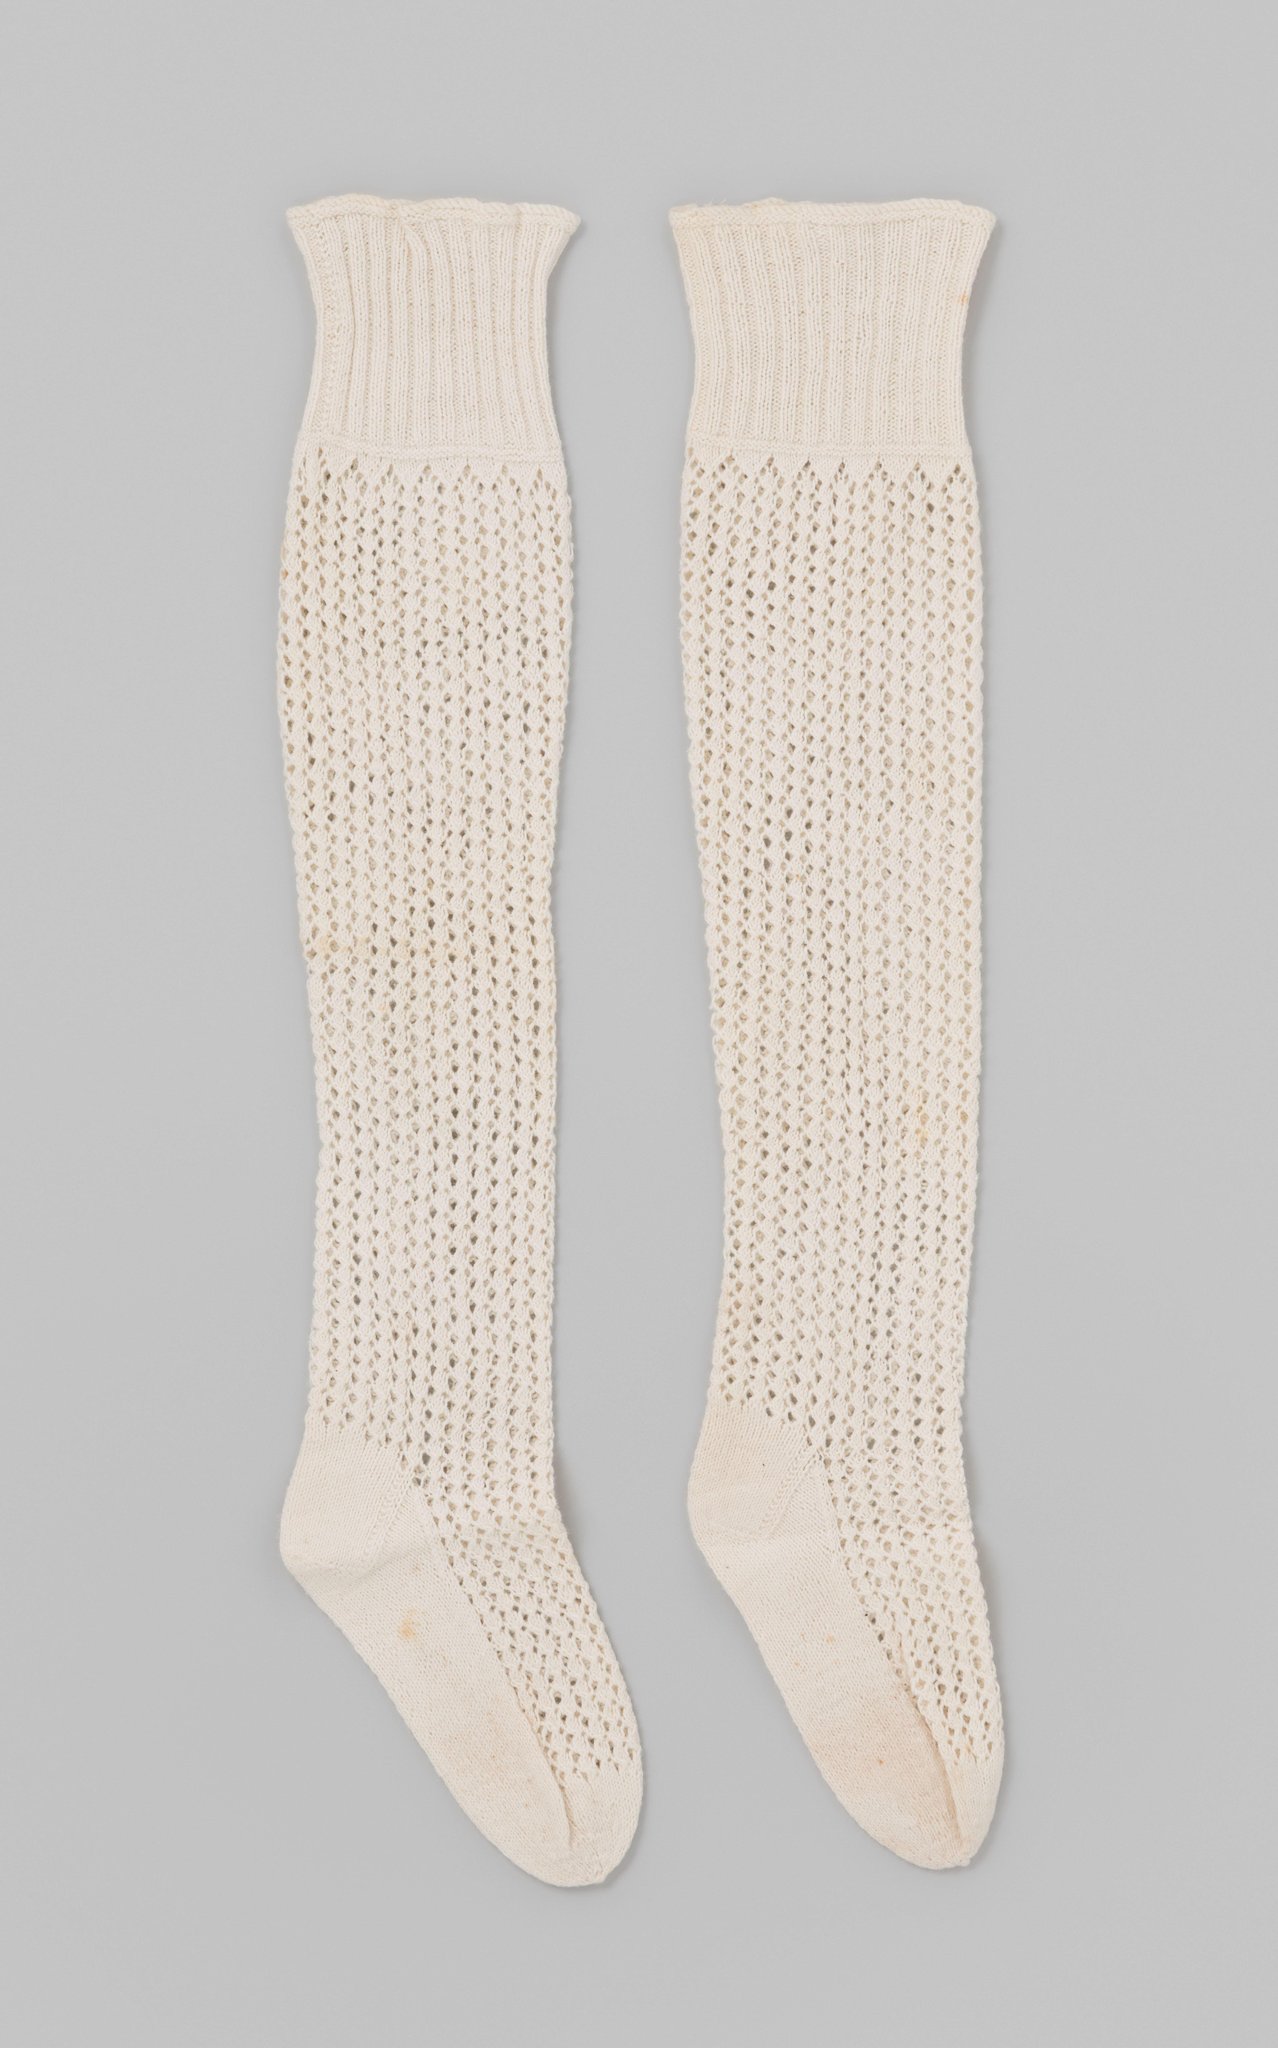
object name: childrenswear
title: Kous van ajour gebreid wit katoen, schubachtig patroon, met brede boord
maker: Anonymous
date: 1900-1910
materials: cotton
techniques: embroidery, knitting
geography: surabaya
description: Vijf paar meisjeskousen in opvolgende maken, ca 1900-1910. A-jour breiwerk in wit katoen, uitgevoerd door de grootmoeder van de schenkster, mevr. De Jong te Soerabaje.